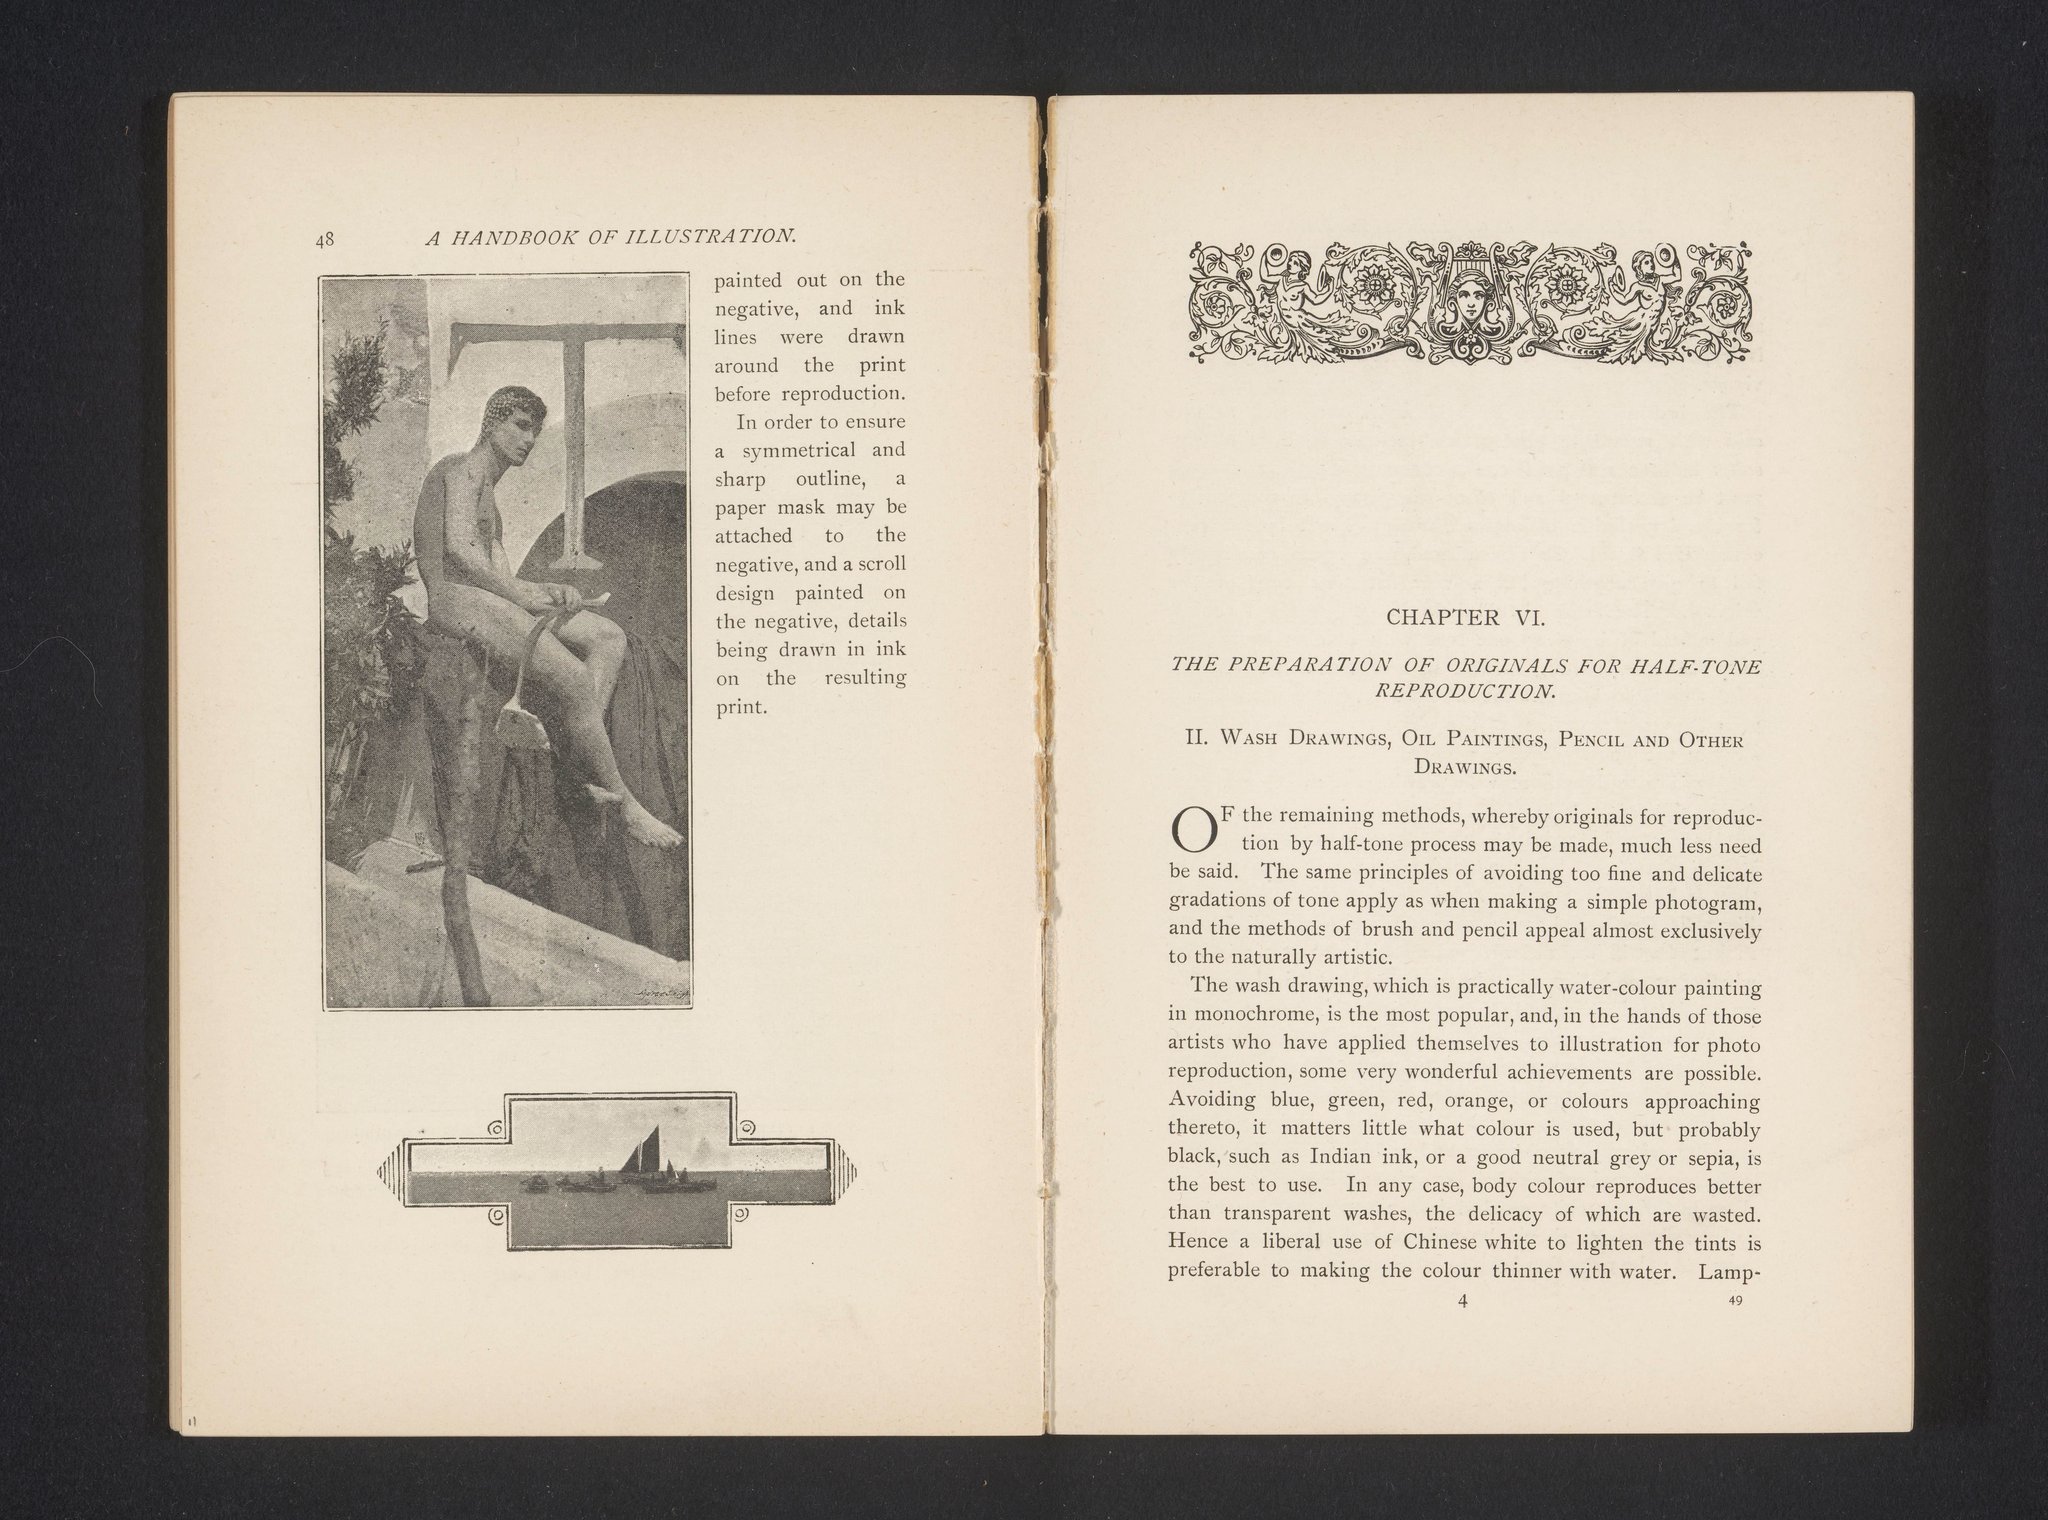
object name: photomechanical print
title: Fotoreproducties van een illustratie van een zittend man naast een letter T en een zeegezicht met boten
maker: Anonymous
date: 1884-1894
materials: paper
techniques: autotype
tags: ships (in general), illustration ~ printed matter, book